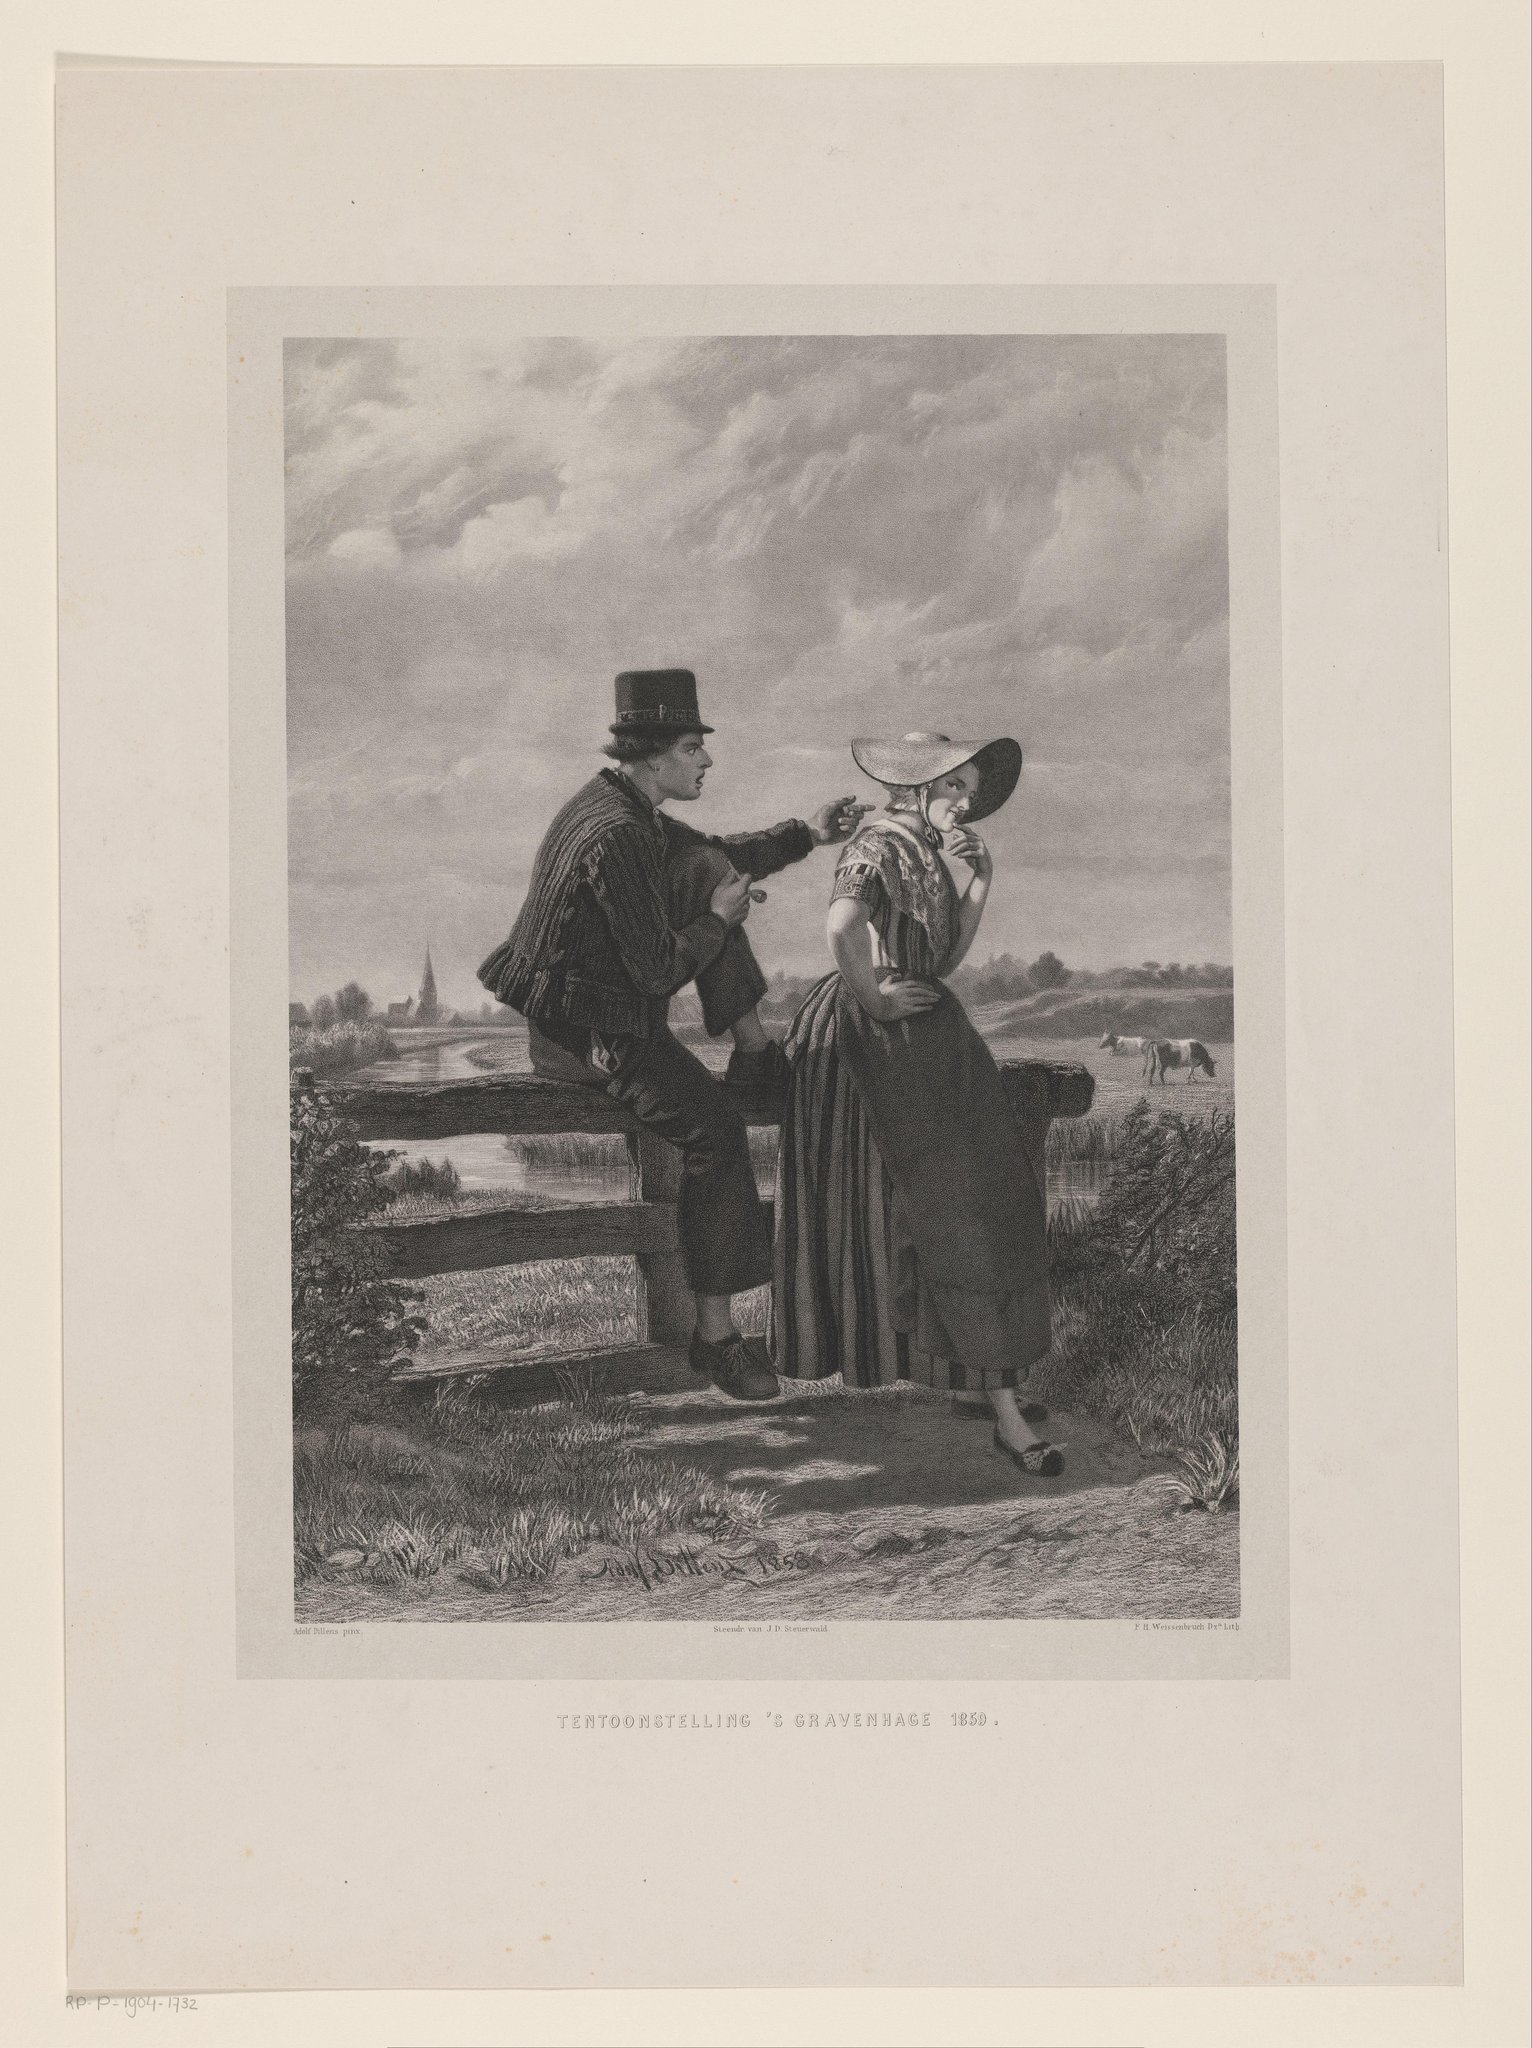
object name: print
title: Le flirt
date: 1858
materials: paper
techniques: lithograph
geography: netherlands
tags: farmers, lovers; courting, flirting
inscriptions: collector's mark: Lugt 2228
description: Een Zeeuws meisje leunend tegen een hek flirt met een Zeeuwse boer met pijp, zittend op het hek. In de achtergrond koeien in een wei, water en een kerktoren.